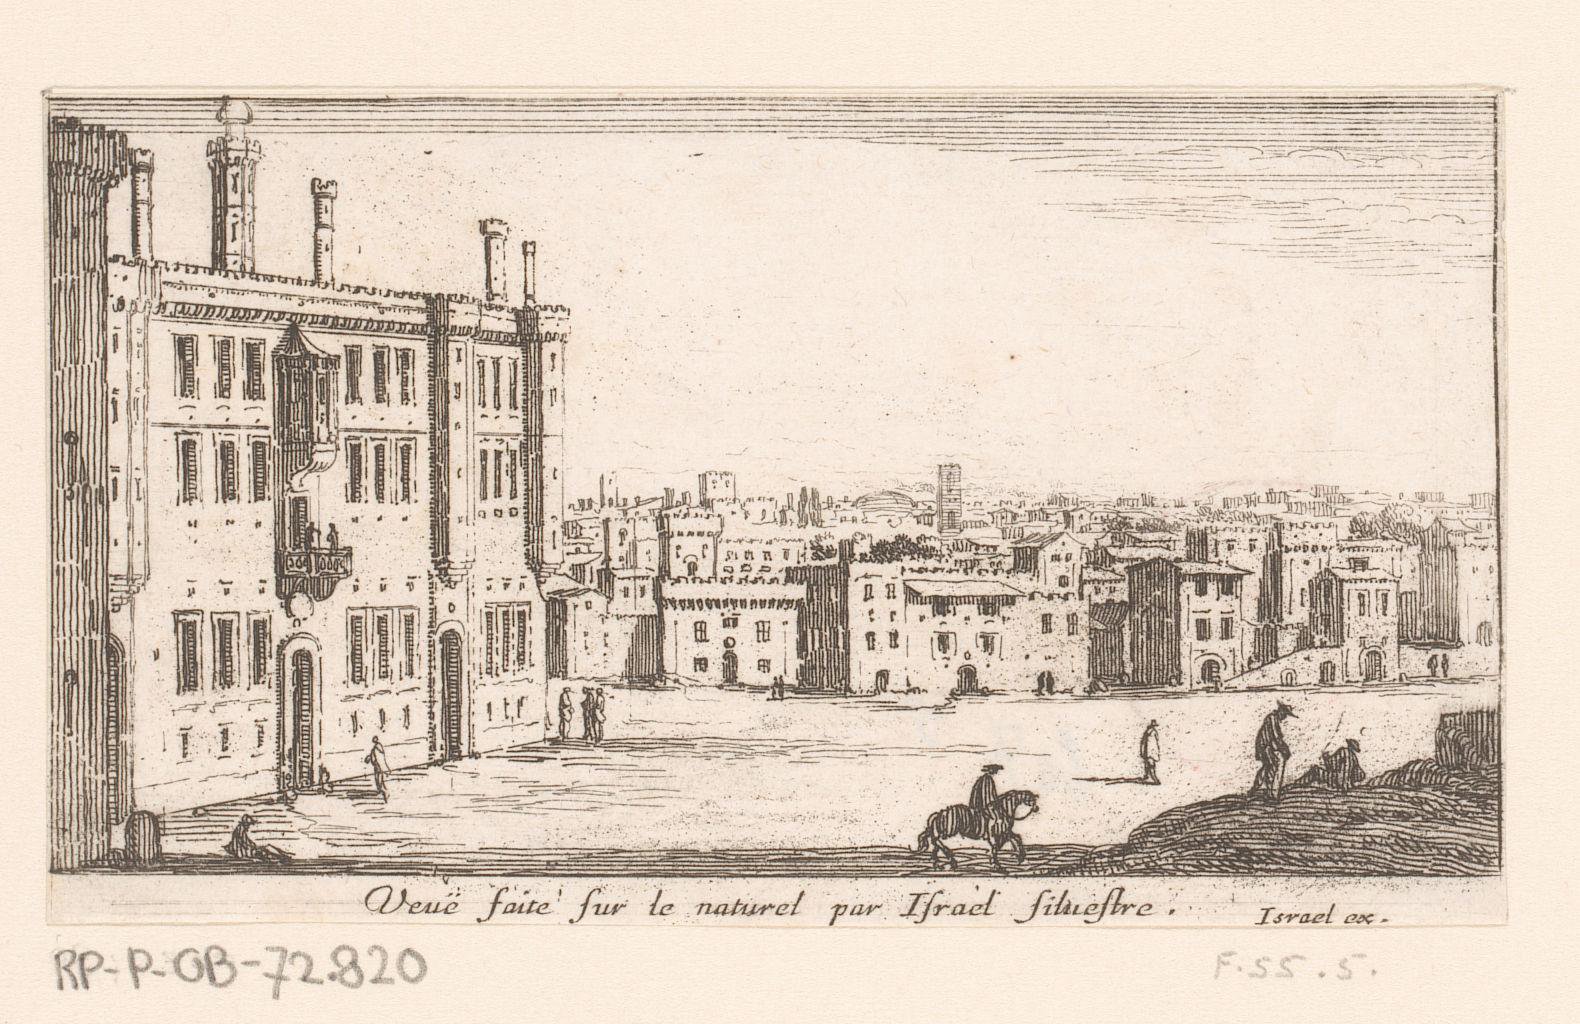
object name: print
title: Veue faite sur le naturel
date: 1631-1661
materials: paper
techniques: etching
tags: city-view, and landscape with man-made constructions (+ city(-scape) with figures, staffage)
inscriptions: collector's mark: Lugt 240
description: Prent maakt deel uit van een ongenummerde serie van zestien prenten.